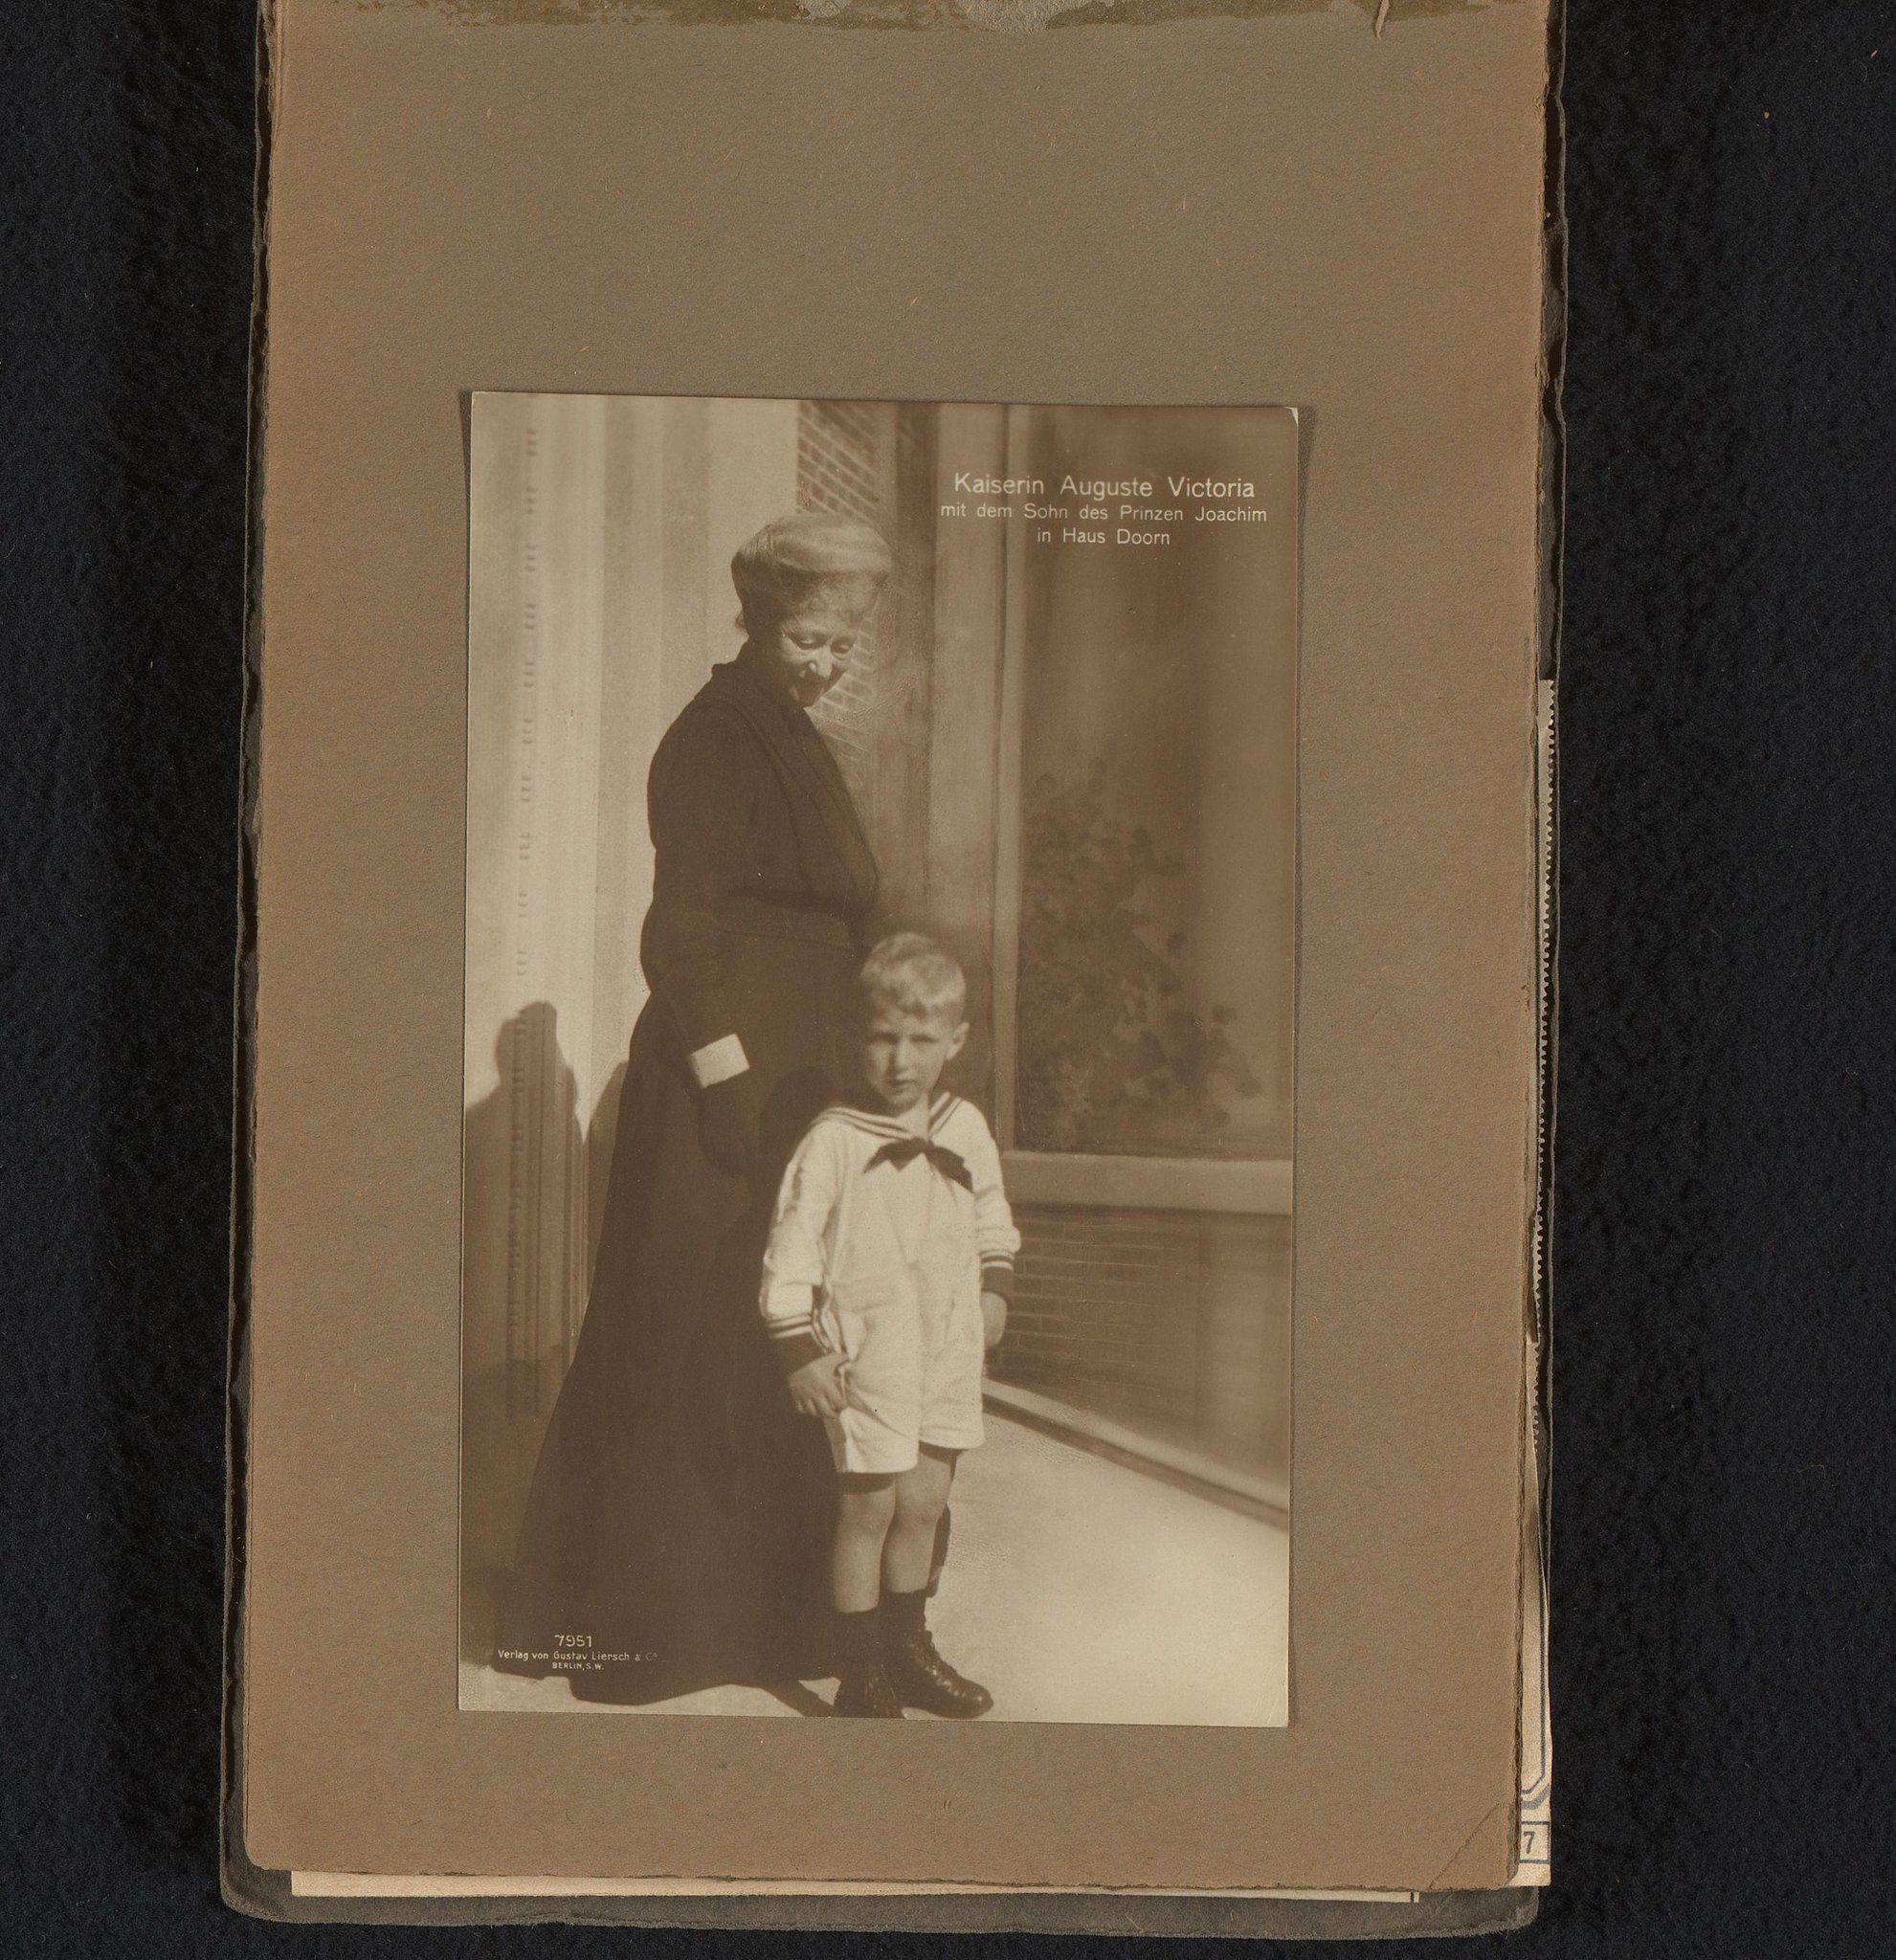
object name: photograph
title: Kaiserin Auguste Victoria mit dem Sohn des Prinzen Joachim in Haus Doorn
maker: Anonymous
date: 1919-1925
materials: paper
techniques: gelatin silver print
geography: huis doorn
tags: augusta victoria (keizerin van duitsland), prince, queen, empress, etc. (wife of a ruler), historical persons